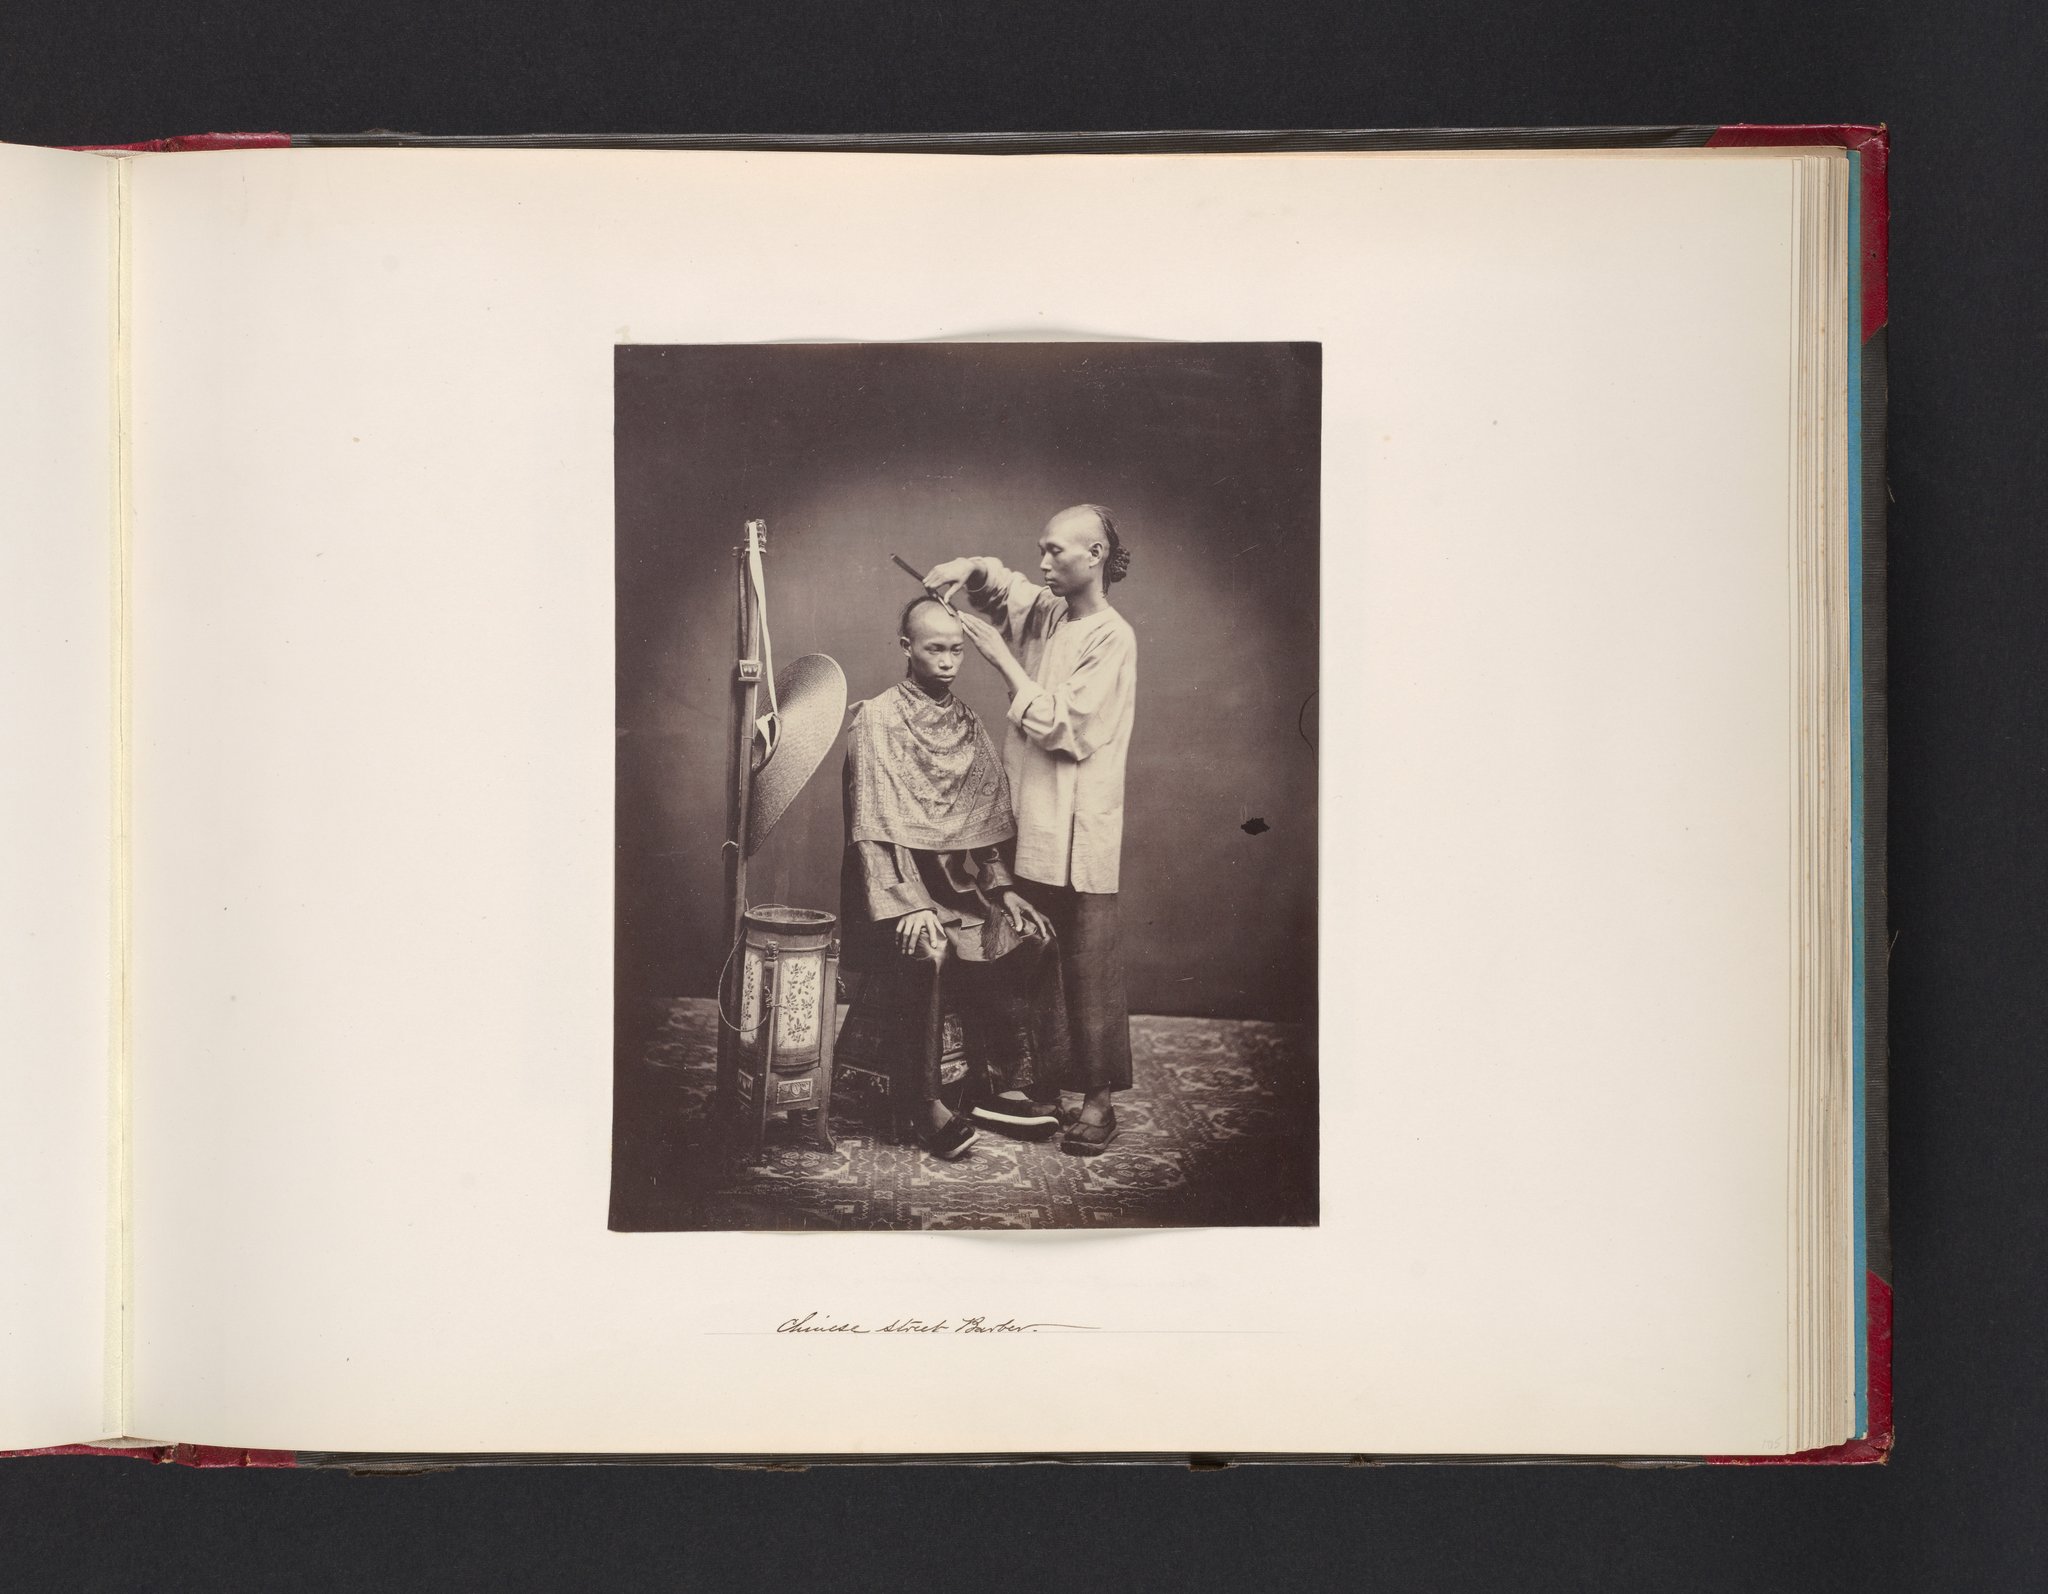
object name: photograph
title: Chinese Street Barber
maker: john thomson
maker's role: artist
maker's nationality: british, scottish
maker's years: 1837-1921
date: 1865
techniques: albumen silver print, glass negative